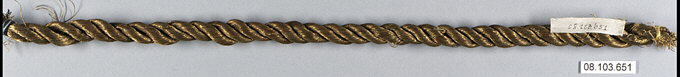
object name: cord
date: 1801-1900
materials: metal thread